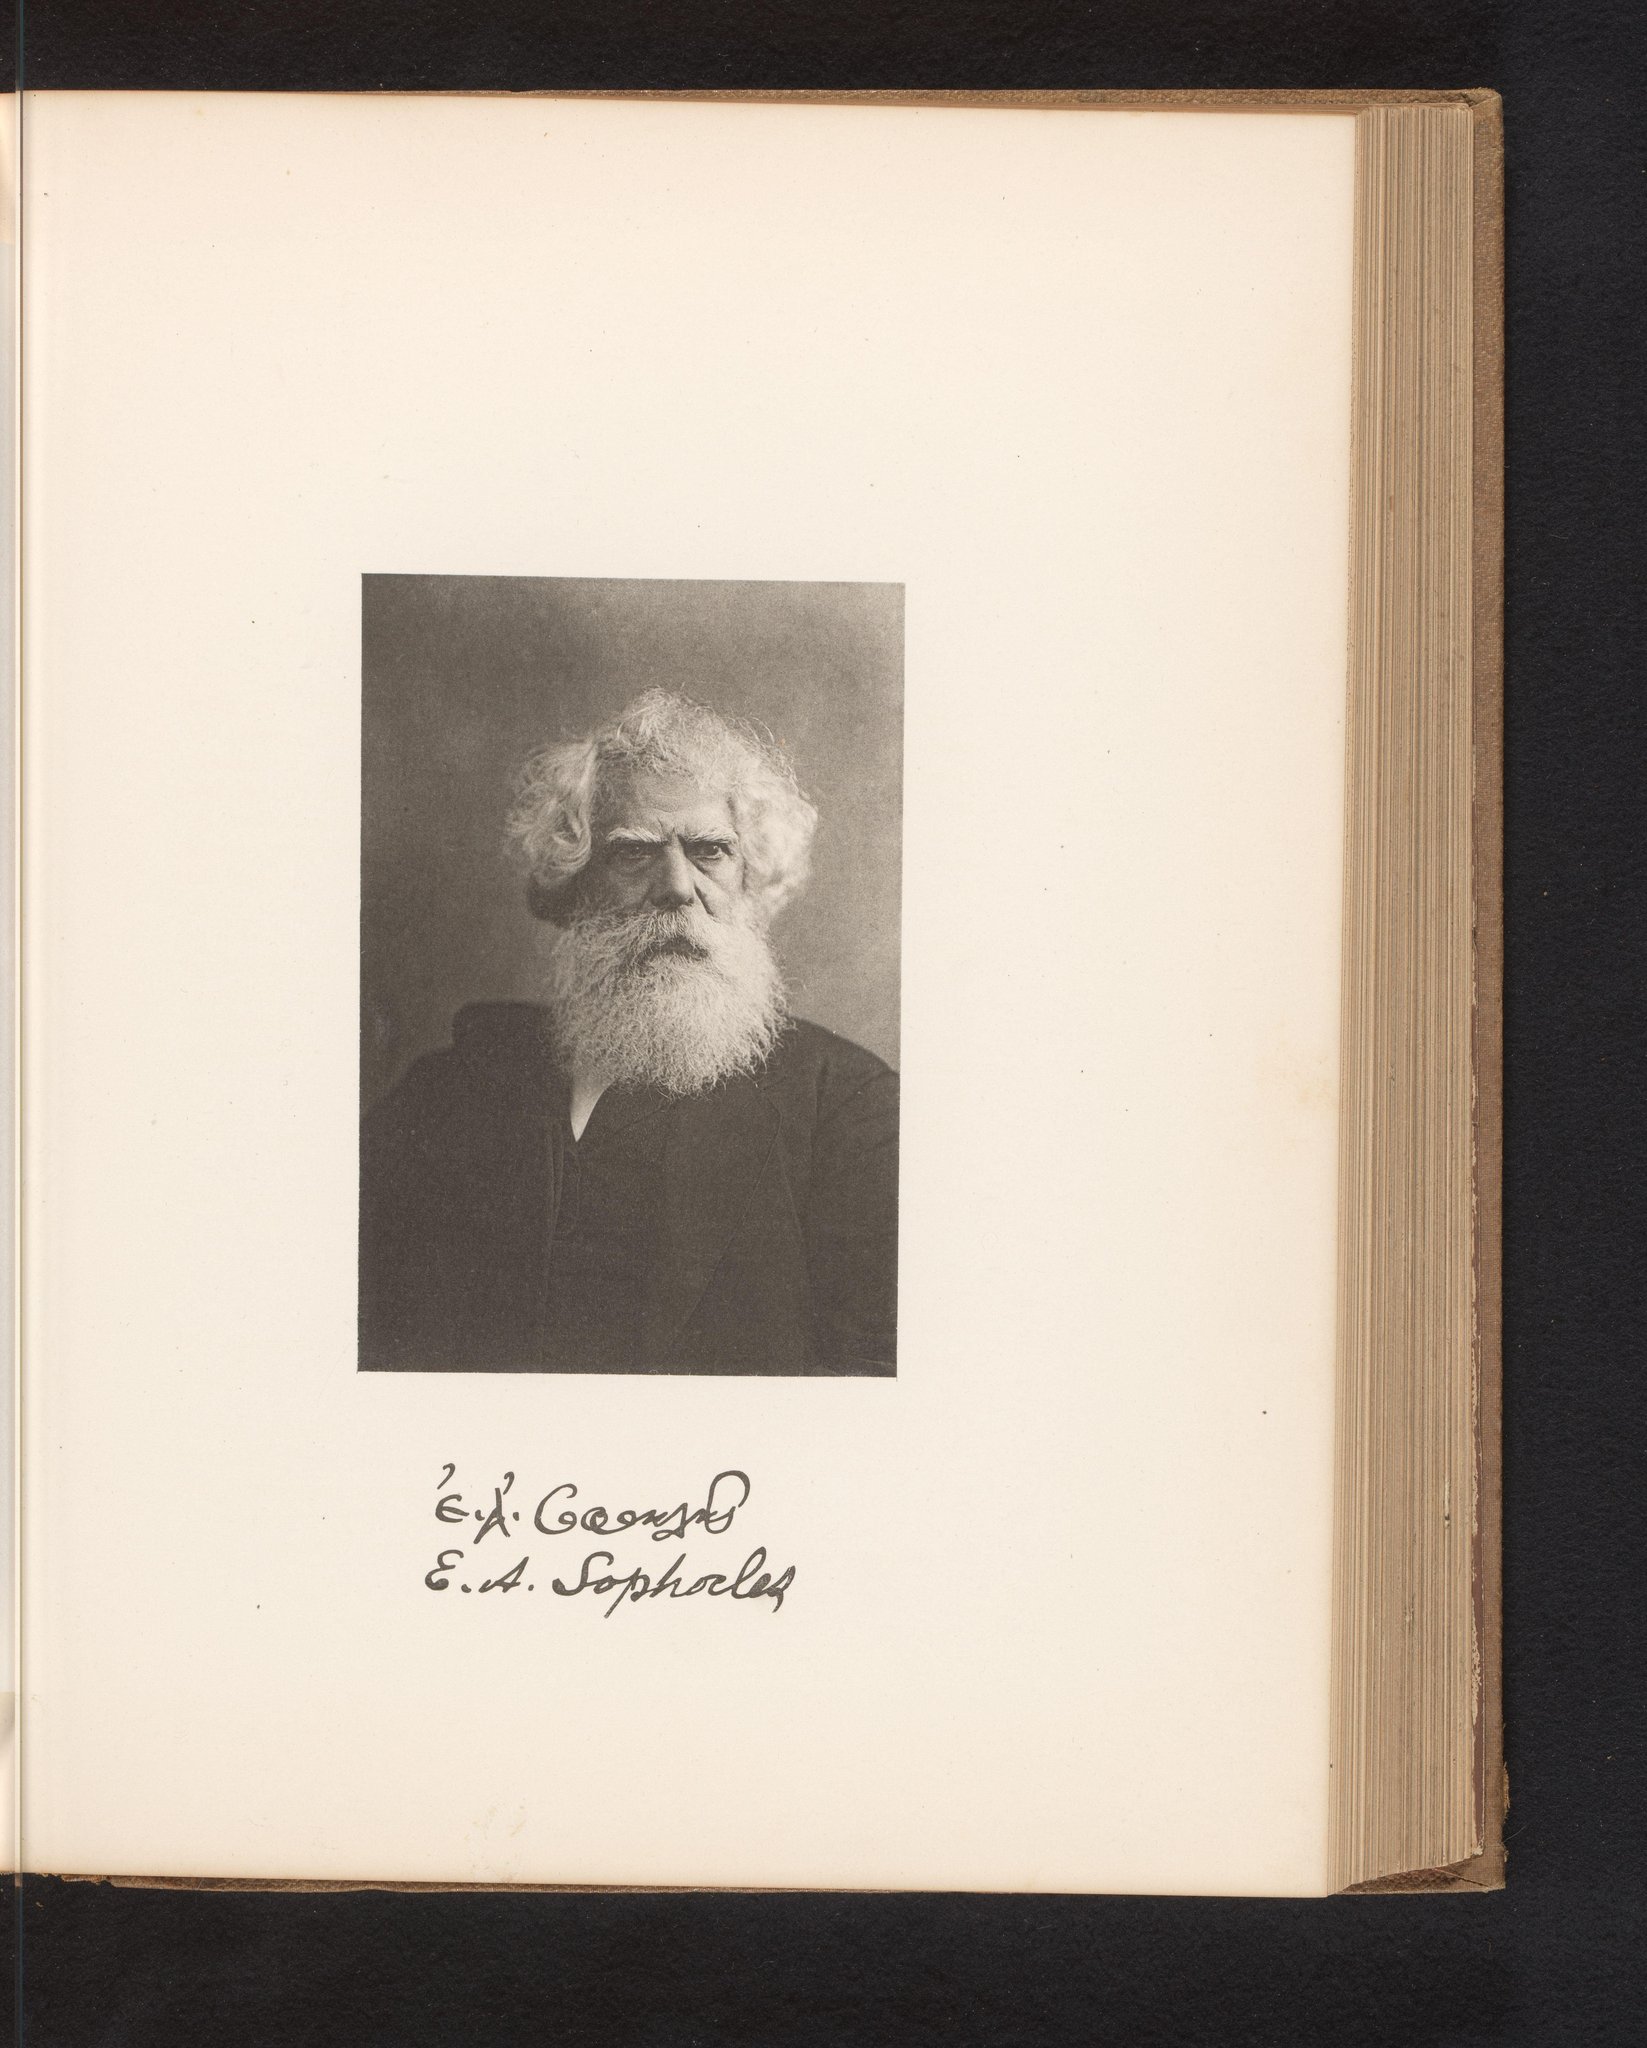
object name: photomechanical print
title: Portret van Evangelinos Apostolides Sophokles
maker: Anonymous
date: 1870-1875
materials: paper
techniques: photograph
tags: historical persons, scholar, philosopher (+ portrait of scholar, scientist)